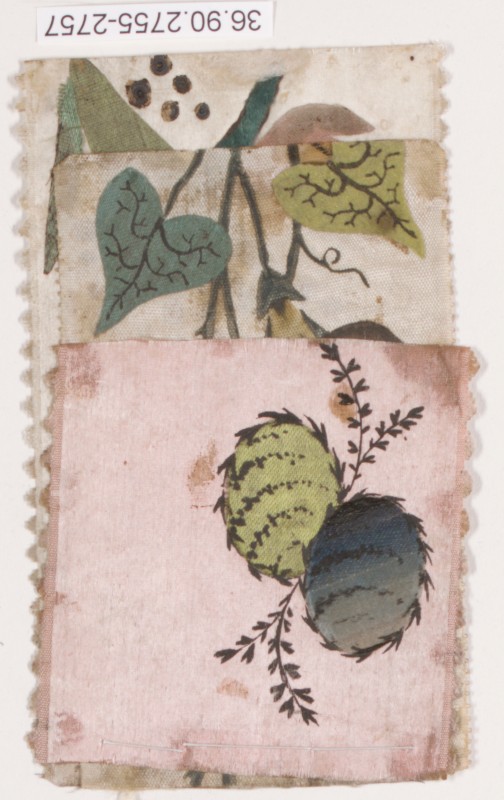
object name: ribbon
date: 1801-1900